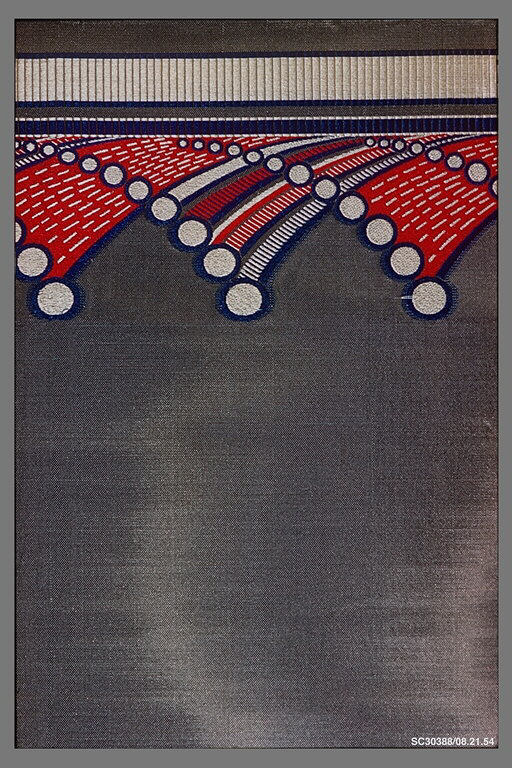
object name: textile sample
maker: Anonymous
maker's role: designer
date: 1900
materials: silk